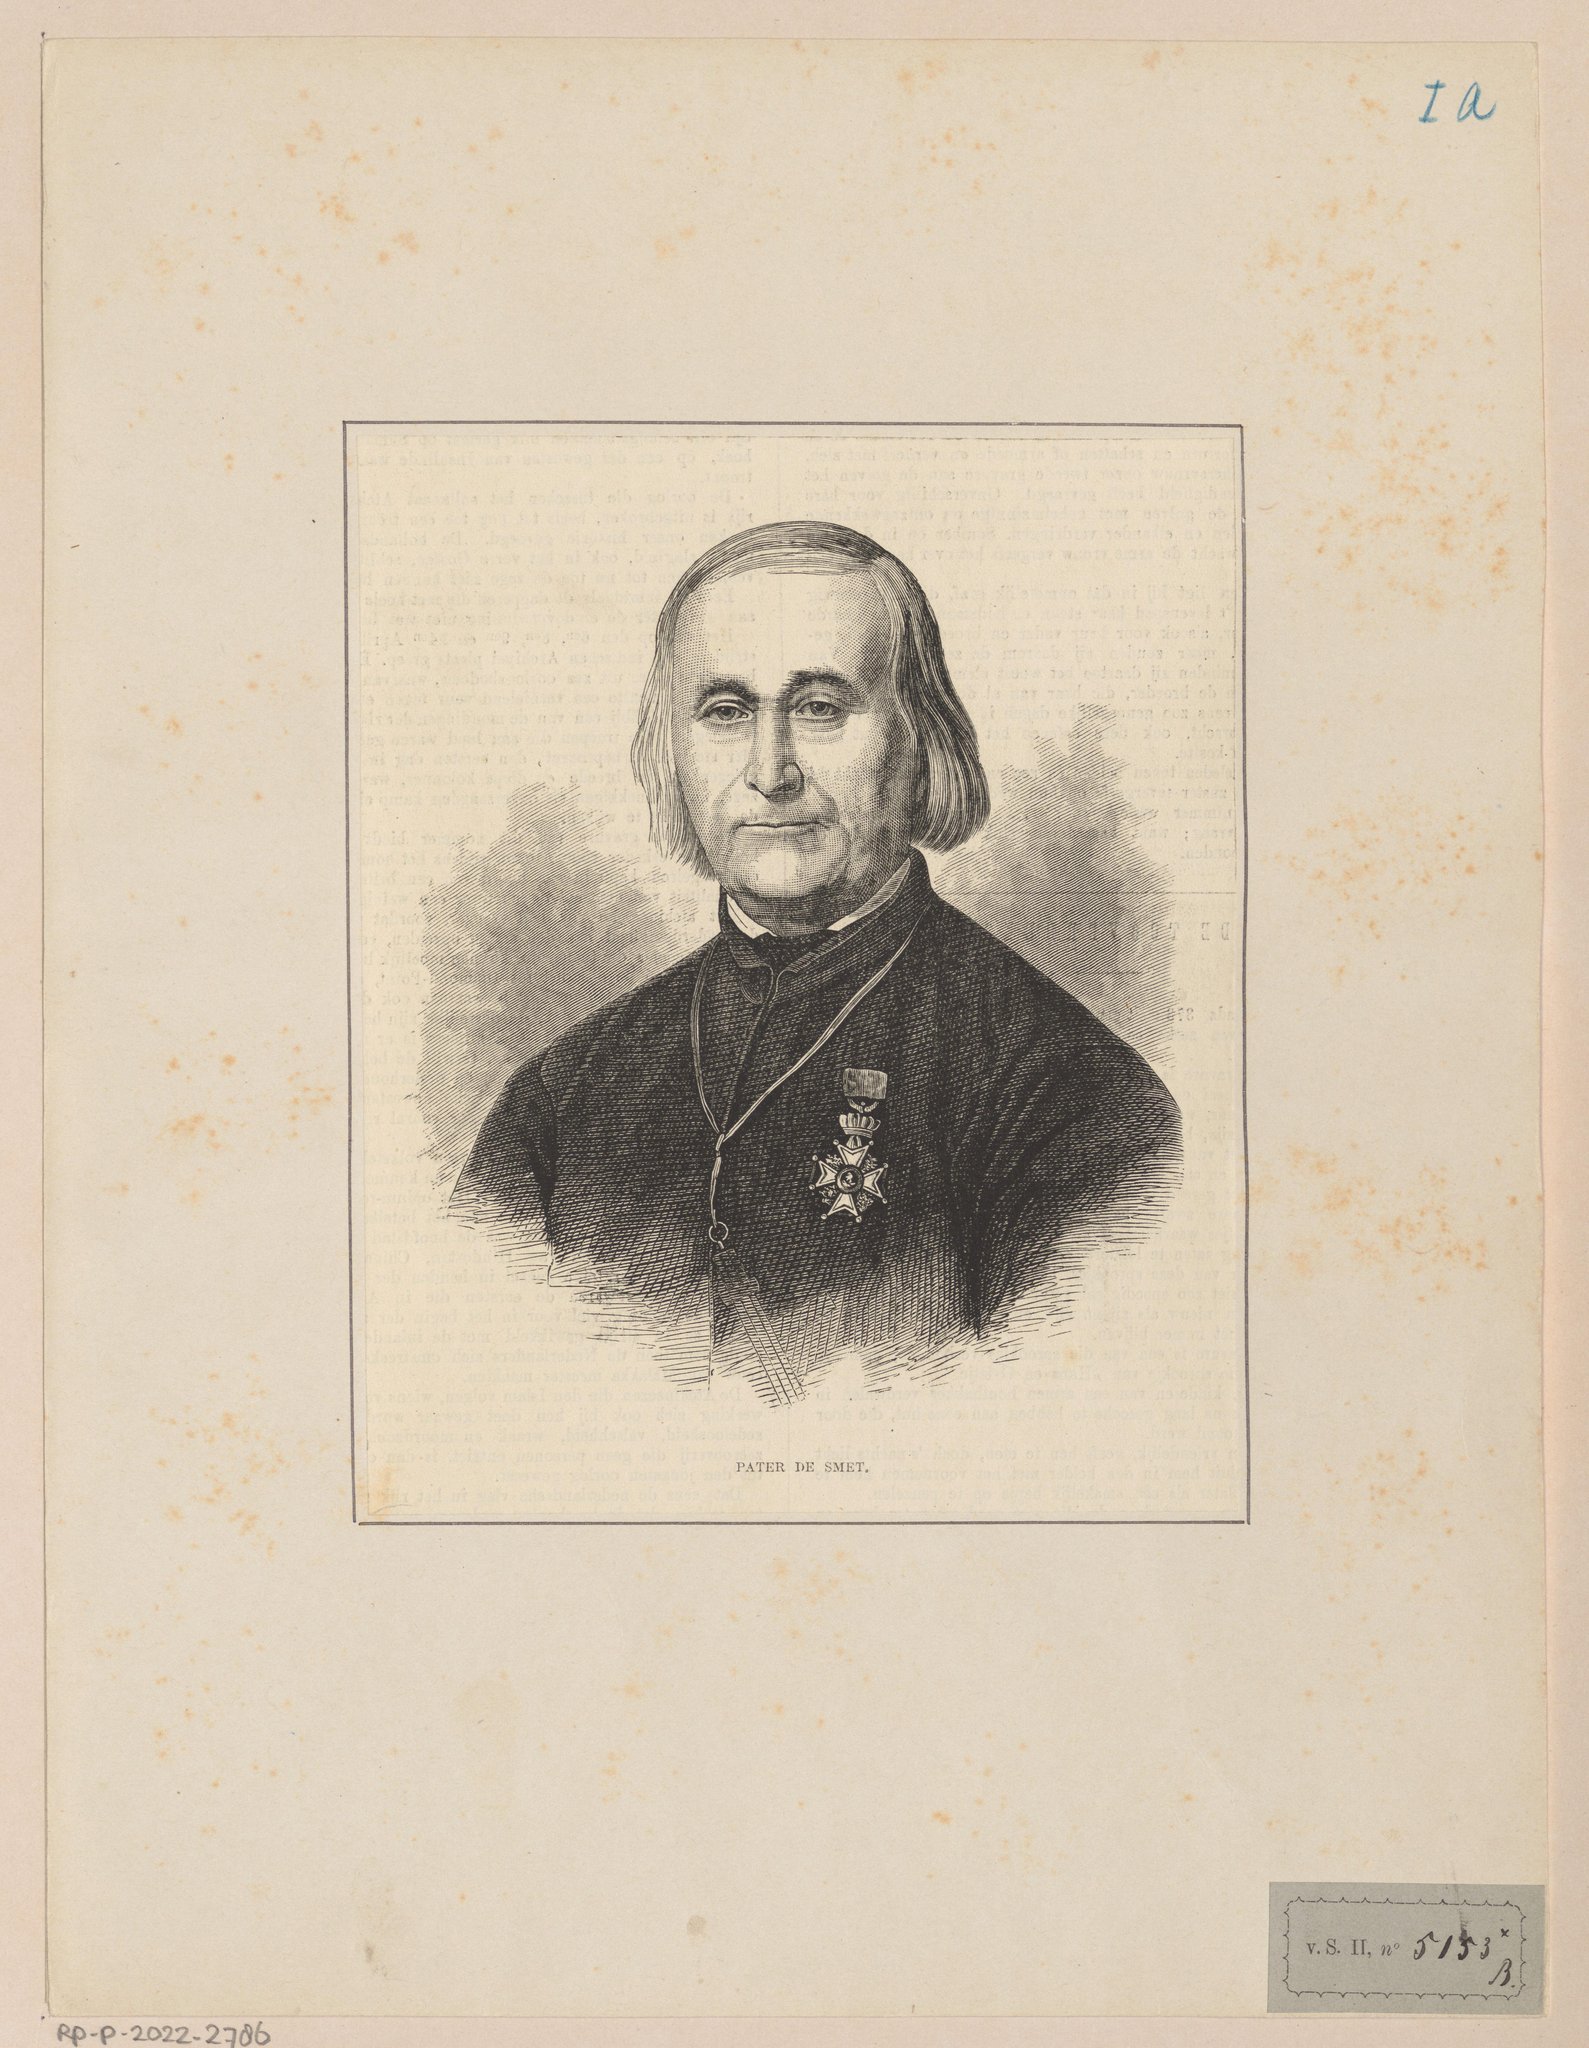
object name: book illustration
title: Portret van Pierre-Jean de Smet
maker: Anonymous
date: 1841-1899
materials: ink, paper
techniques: letterpress printing, pen, snipping, engraving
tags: missionary, historical persons, explorer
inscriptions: inscription: ‘Ia’, : ‘v.S. II, no 5153* B.’